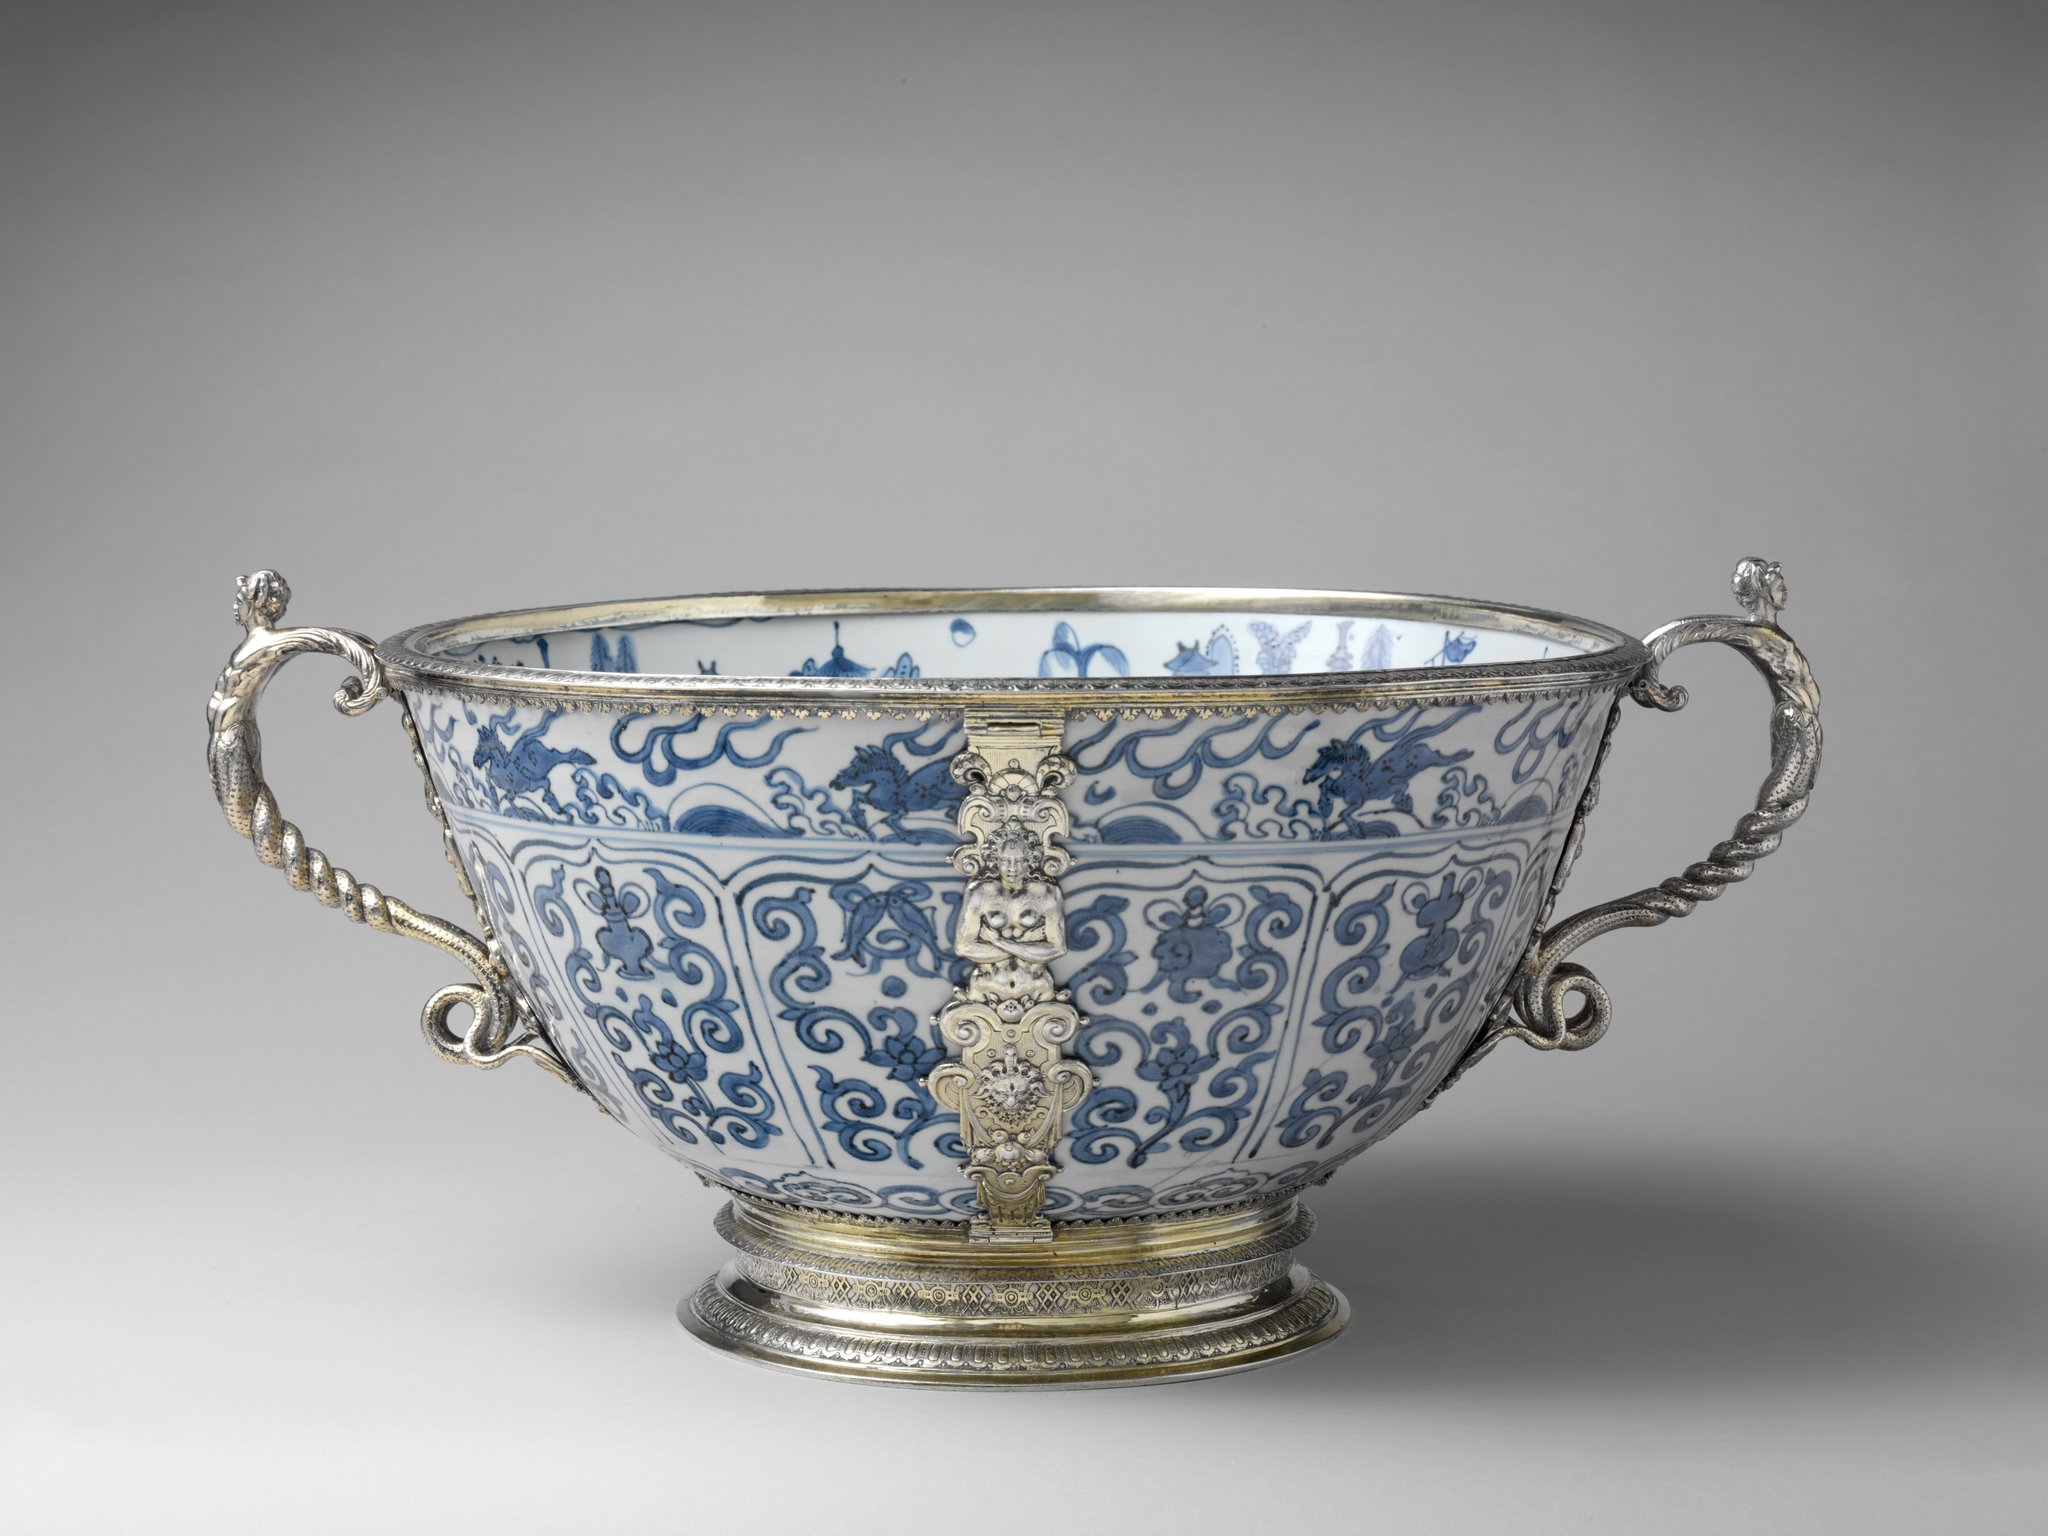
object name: bowl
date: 1585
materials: hard paste porcelain, silver gilt